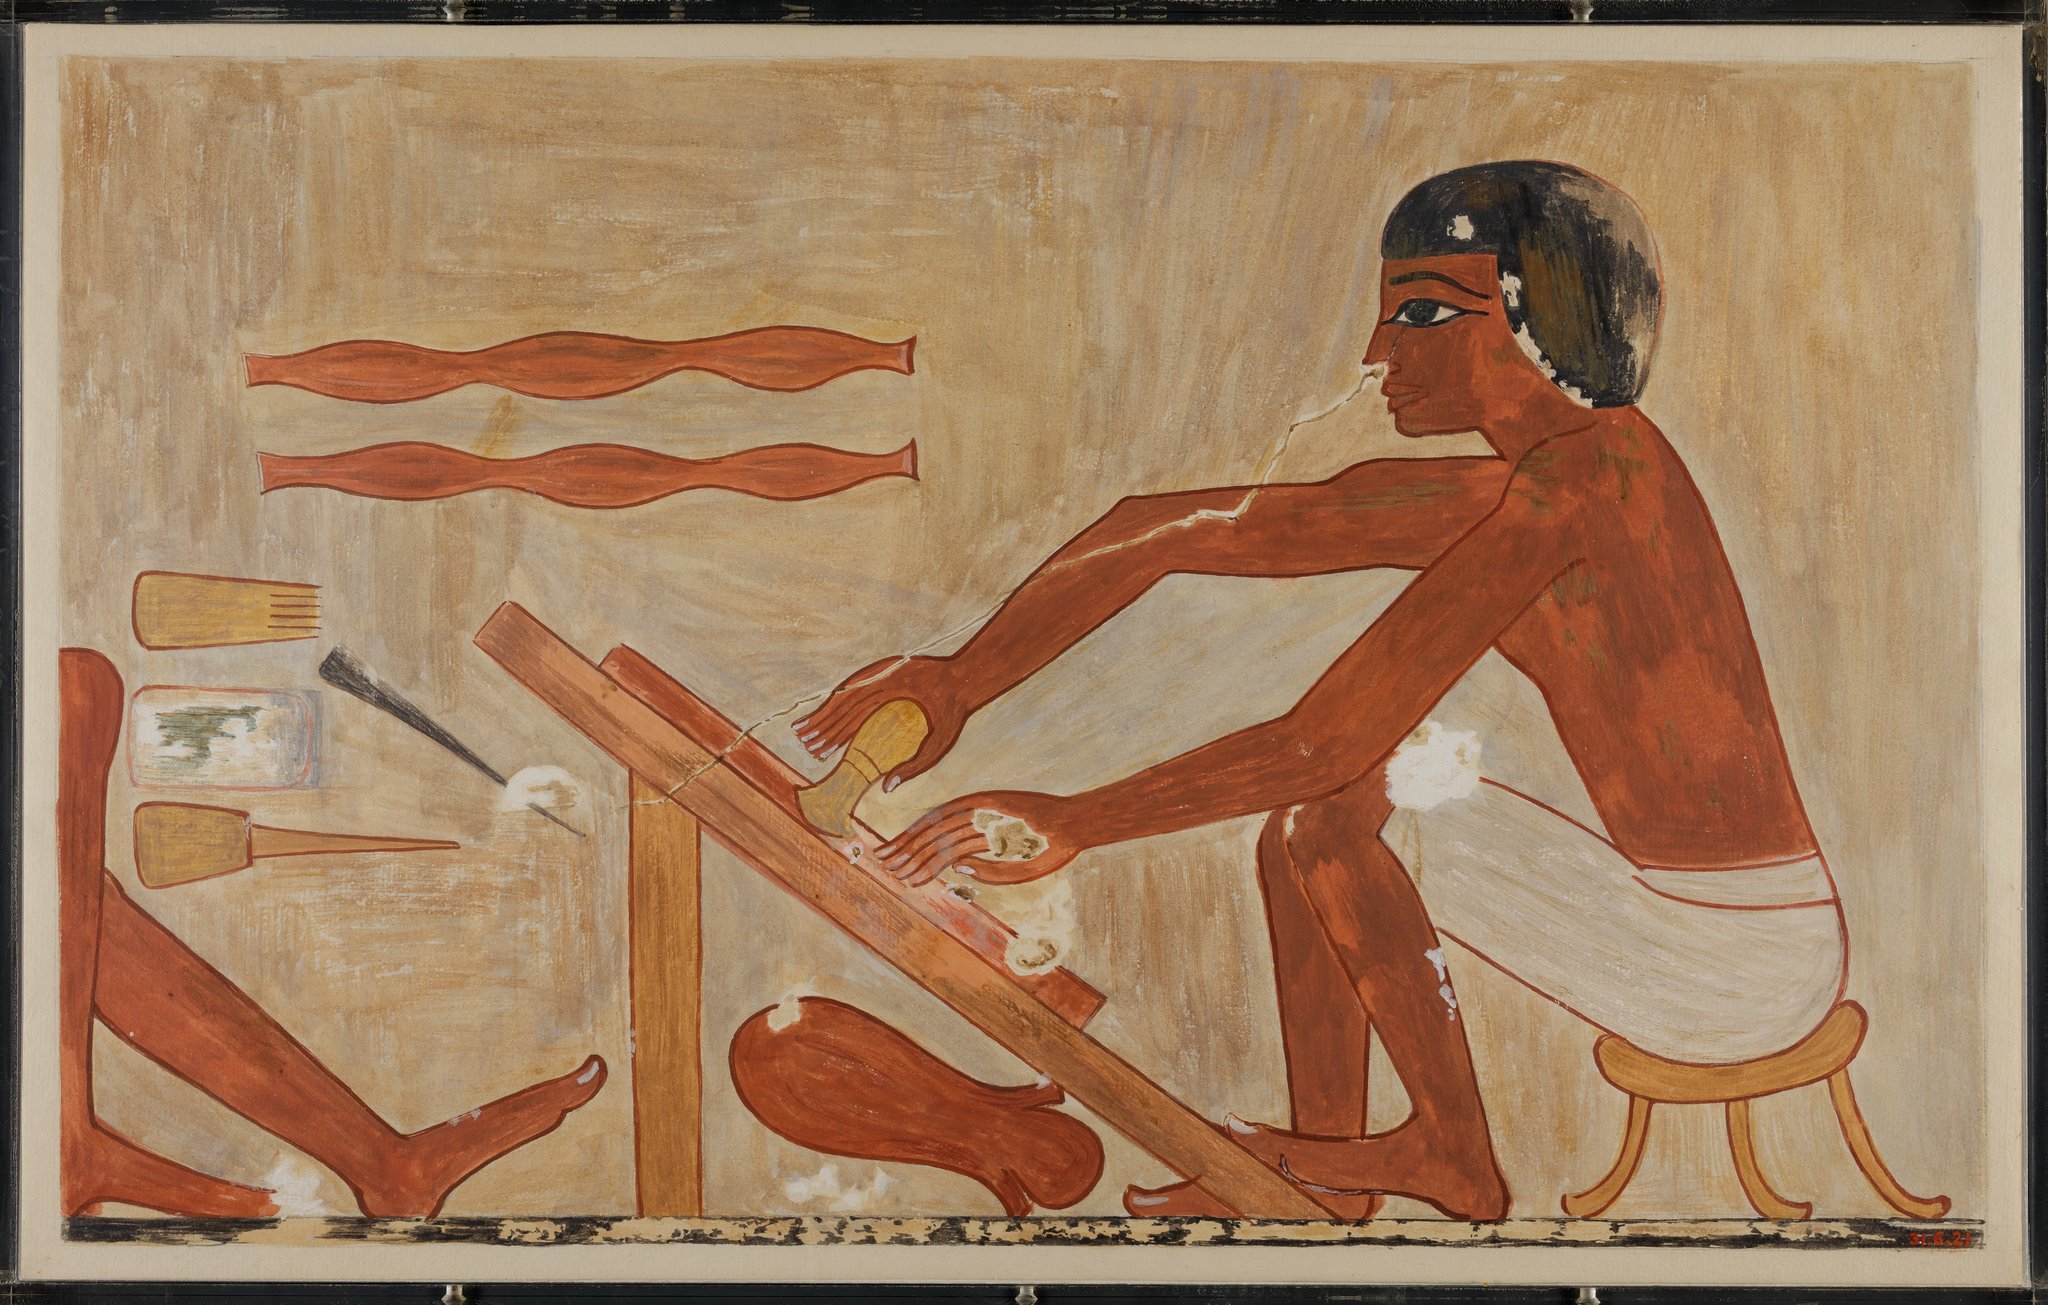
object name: facsimile, rekhmire tt 100, leather work, sandal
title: Leather Working, Tomb of Rekhmire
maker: nina de garis davies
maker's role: artist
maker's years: 1881-1965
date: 1504-1425 BCE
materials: ink, paint, paper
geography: egypt